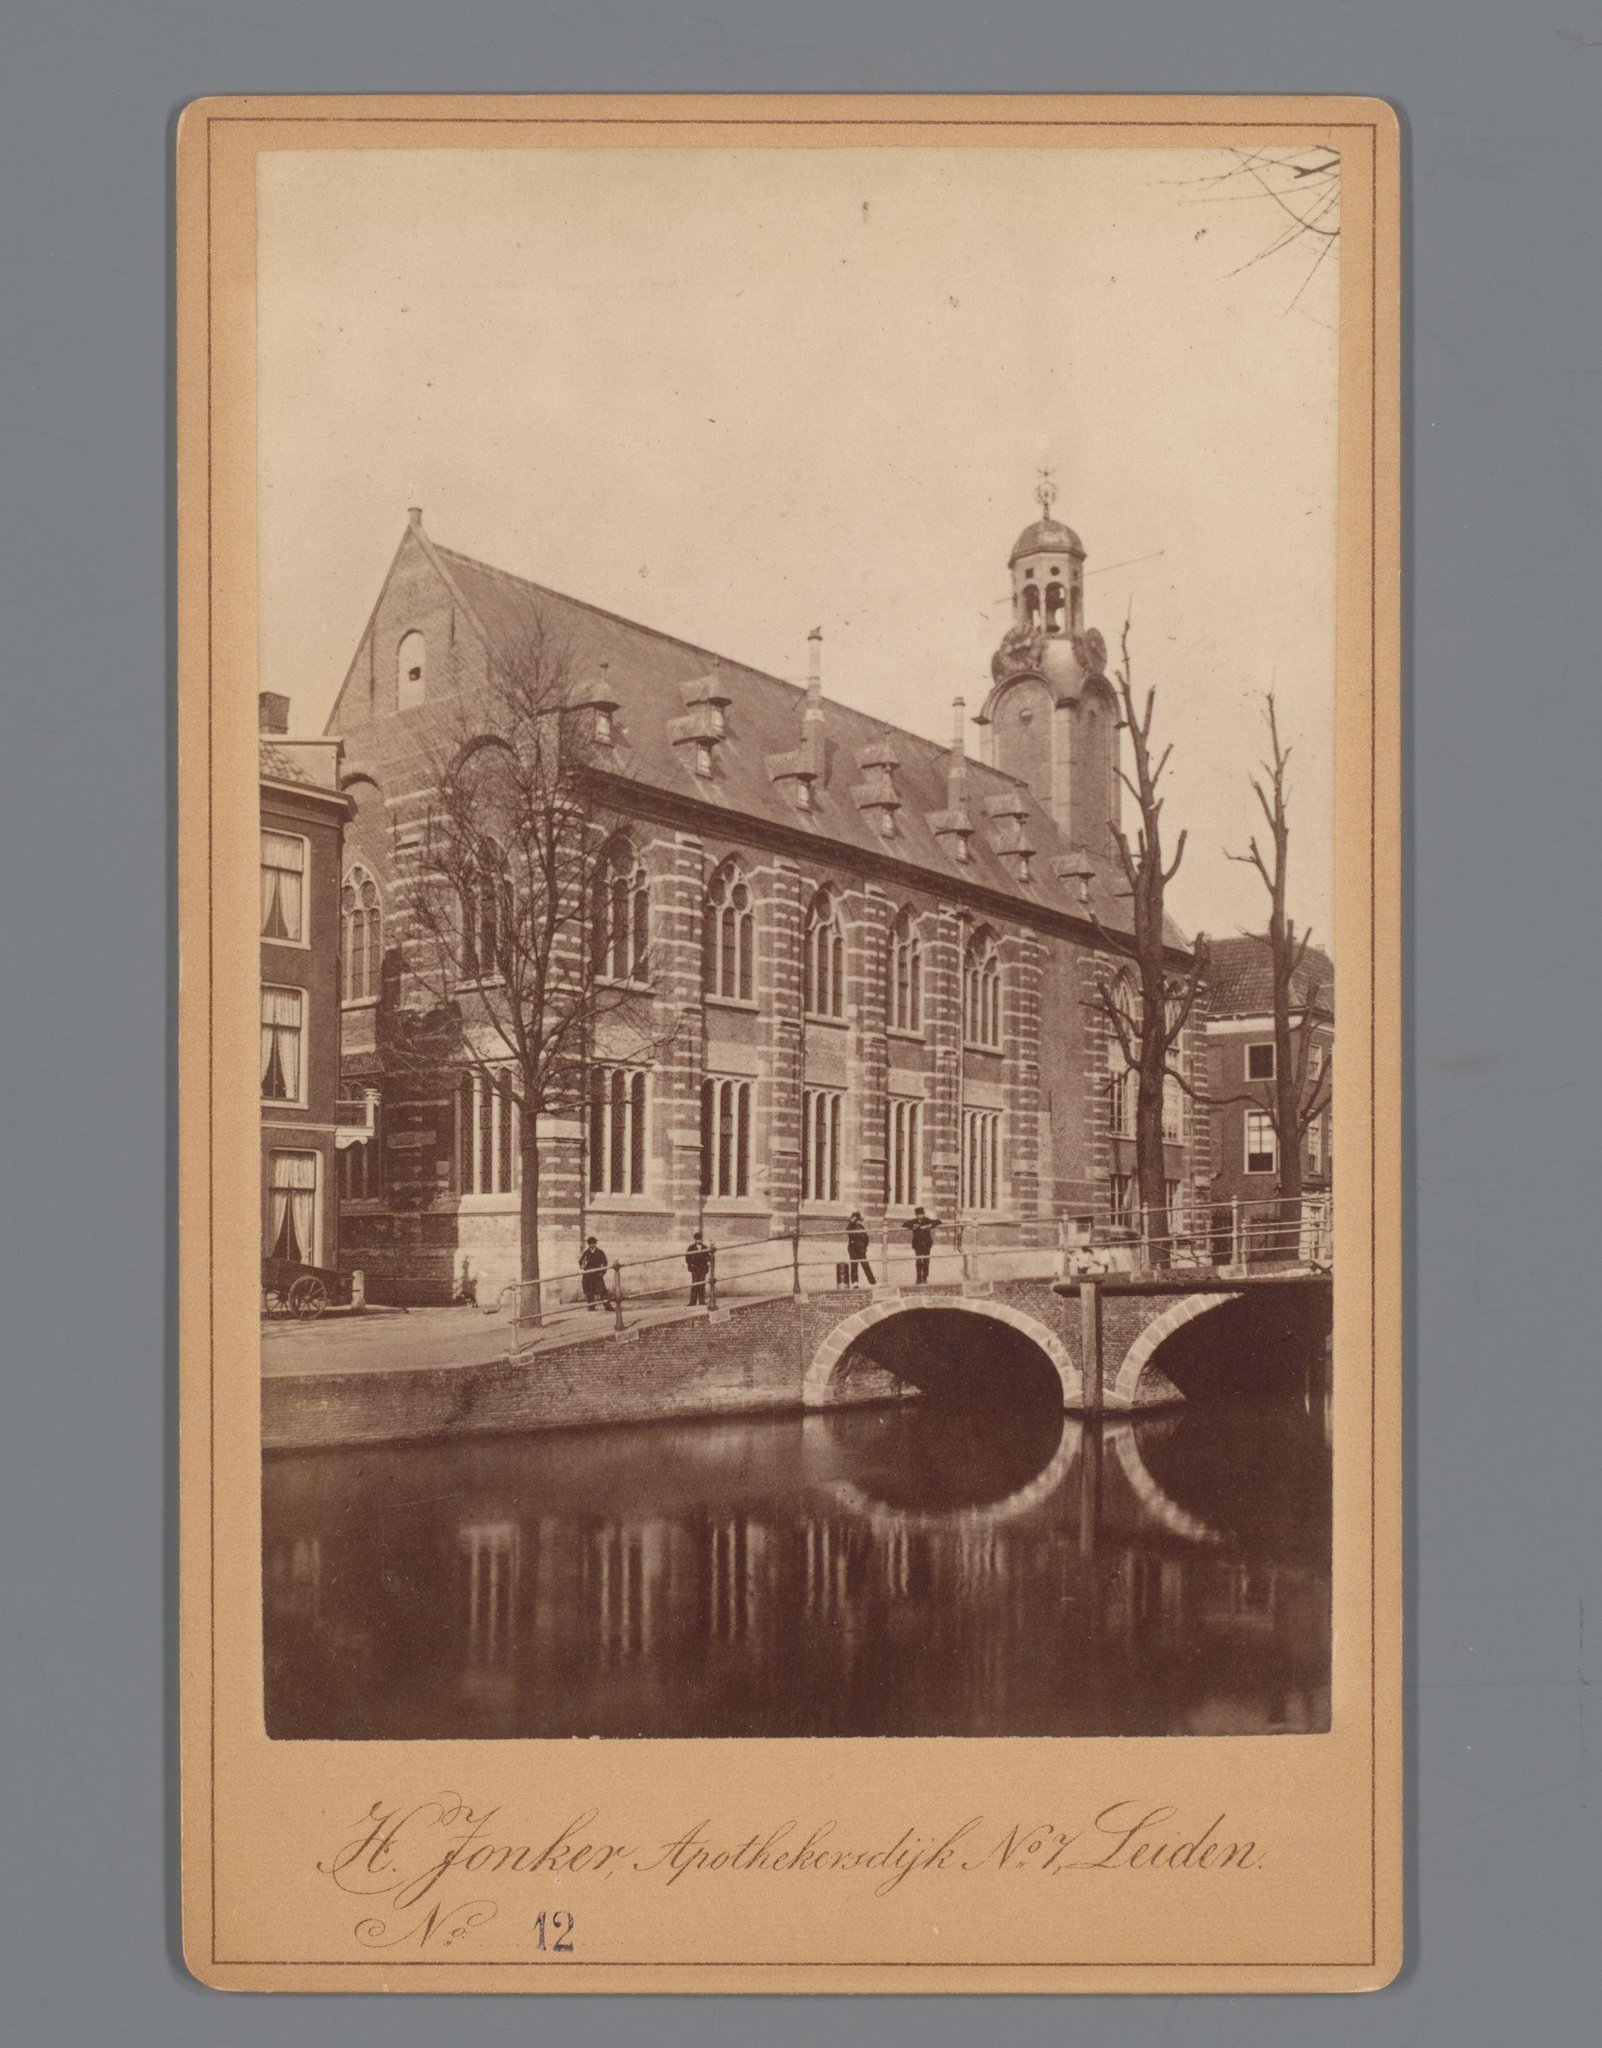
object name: photograph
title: Gezicht op het Academiegebouw van de Universiteit Leiden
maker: hendrik jonker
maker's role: fotograaf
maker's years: 1846-1932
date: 1882-1914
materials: cardboard, photographic support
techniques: albumen print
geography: leiden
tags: university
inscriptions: annotation: ‘De Academie’, inscription: ‘H. Jonker, Apothekersdijk No7, Leiden/ No 12’